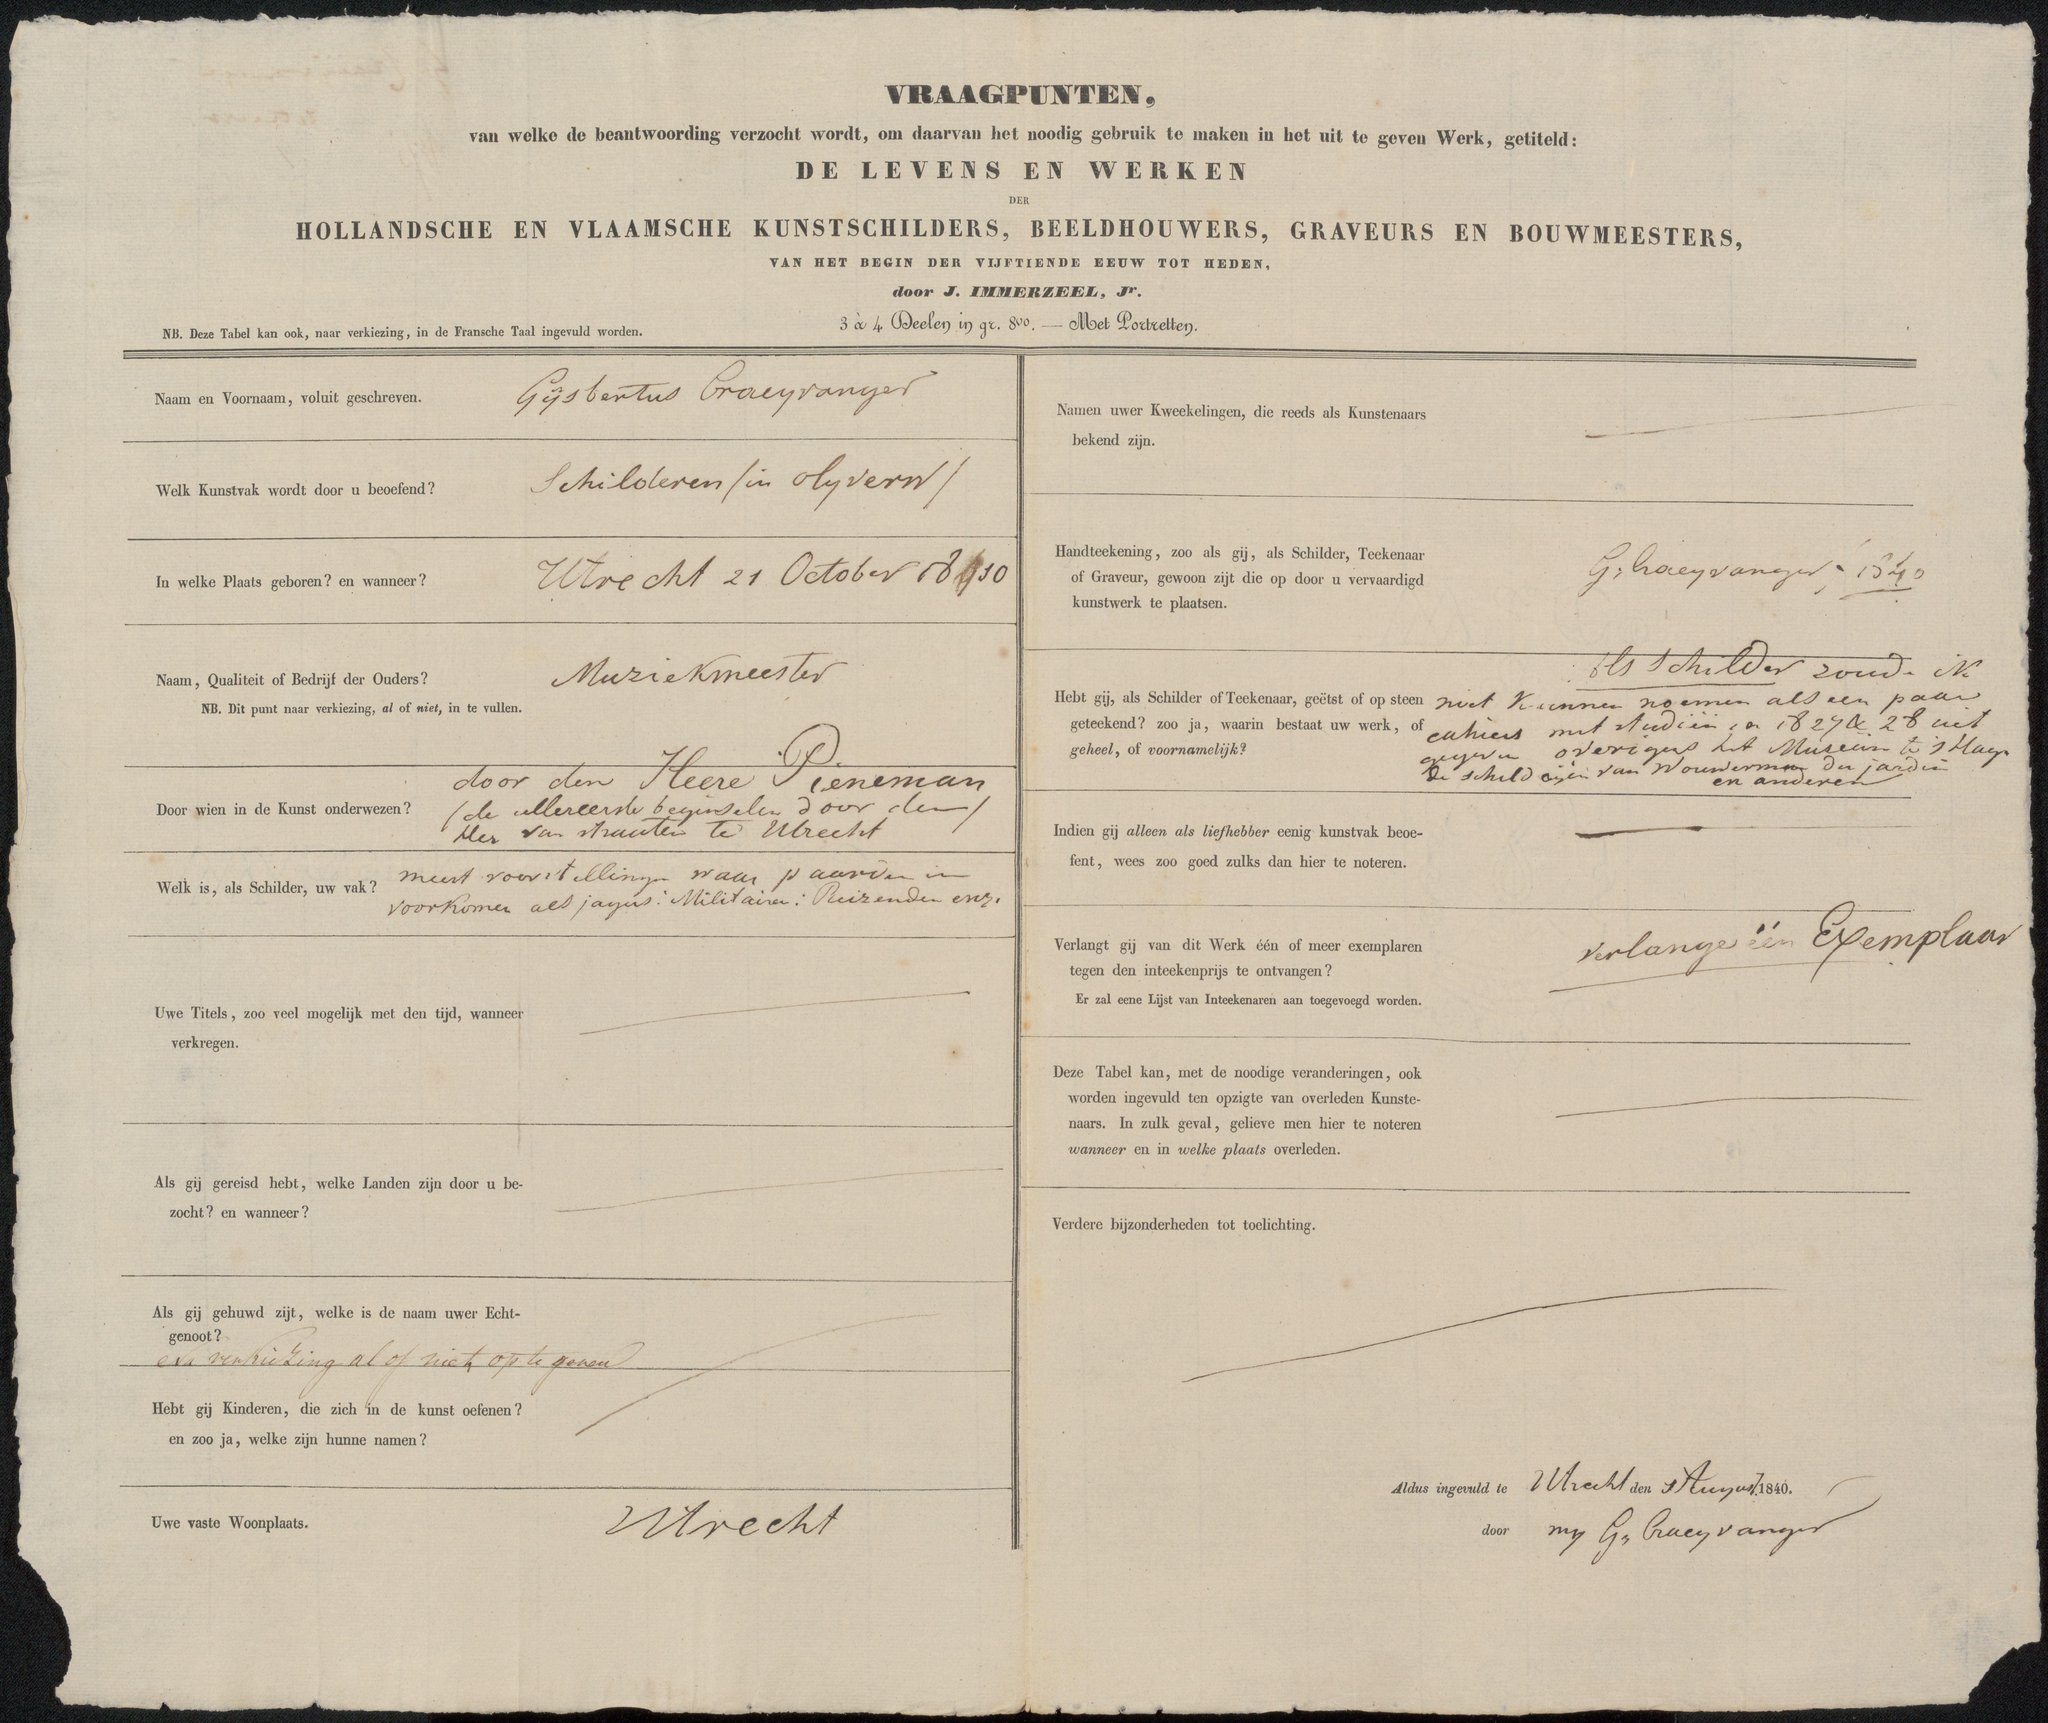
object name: questionnaire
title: Enquêteformulier ingevuld door Gijsbertus Craeyvanger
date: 1840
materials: ink, paper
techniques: pen, printing, writing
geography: utrecht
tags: utrecht, print maker, draughtsman, gijsbertus craeyvanger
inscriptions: inscription: ‘Vraagpunten,/ van welke de beantwoording verzocht wordt, om daarvan het noodig gebruik te maken in het uit te geven Werk, getiteld: De levens en werken/ der Hollandsche en Vlaamsche kunstschilders, beeldhouwers,/ graveurs en bouwmeesters, van het begin der vijftiende eeuw tot heden/ door J. Immerzeel, Jr.’, watermark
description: Opgenomen in: Immerzeel, J. Jr., De levens en werken der Hollandsche en Vlaamsche kunstschilders, beeldhouwers, graveurs en bouwmeesters, van het begin der vijftiende eeuw tot heden, Amsterdam: J.C. van Kesteren, 1842-1843.